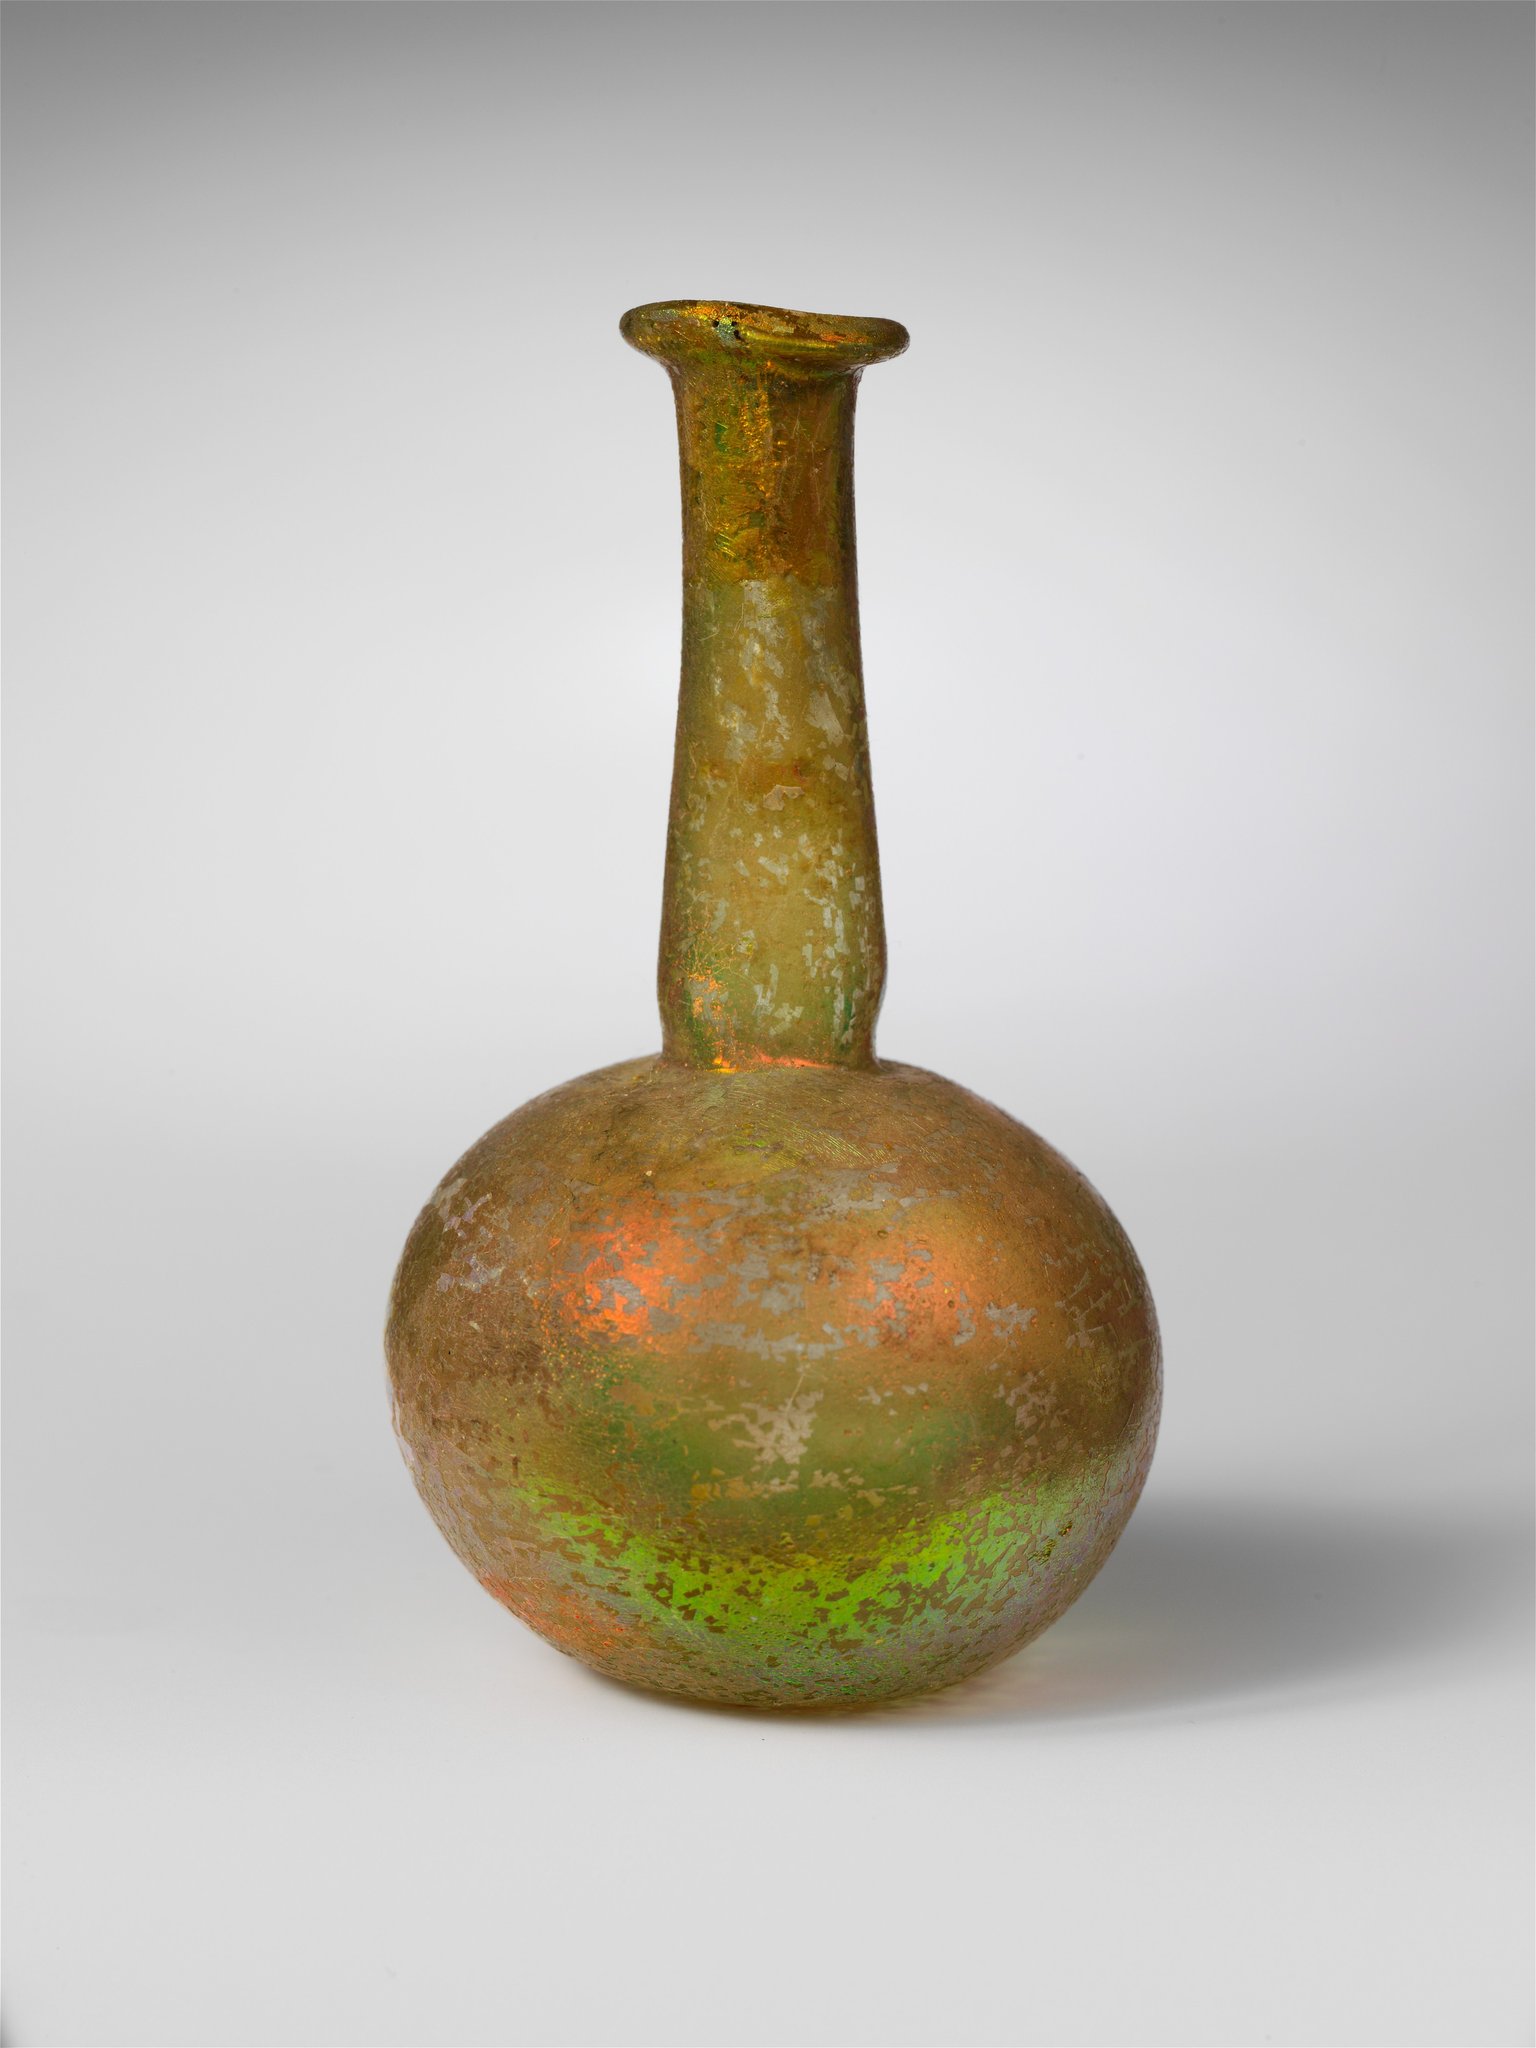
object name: perfume bottle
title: Glass perfume bottle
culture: roman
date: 101-300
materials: glass